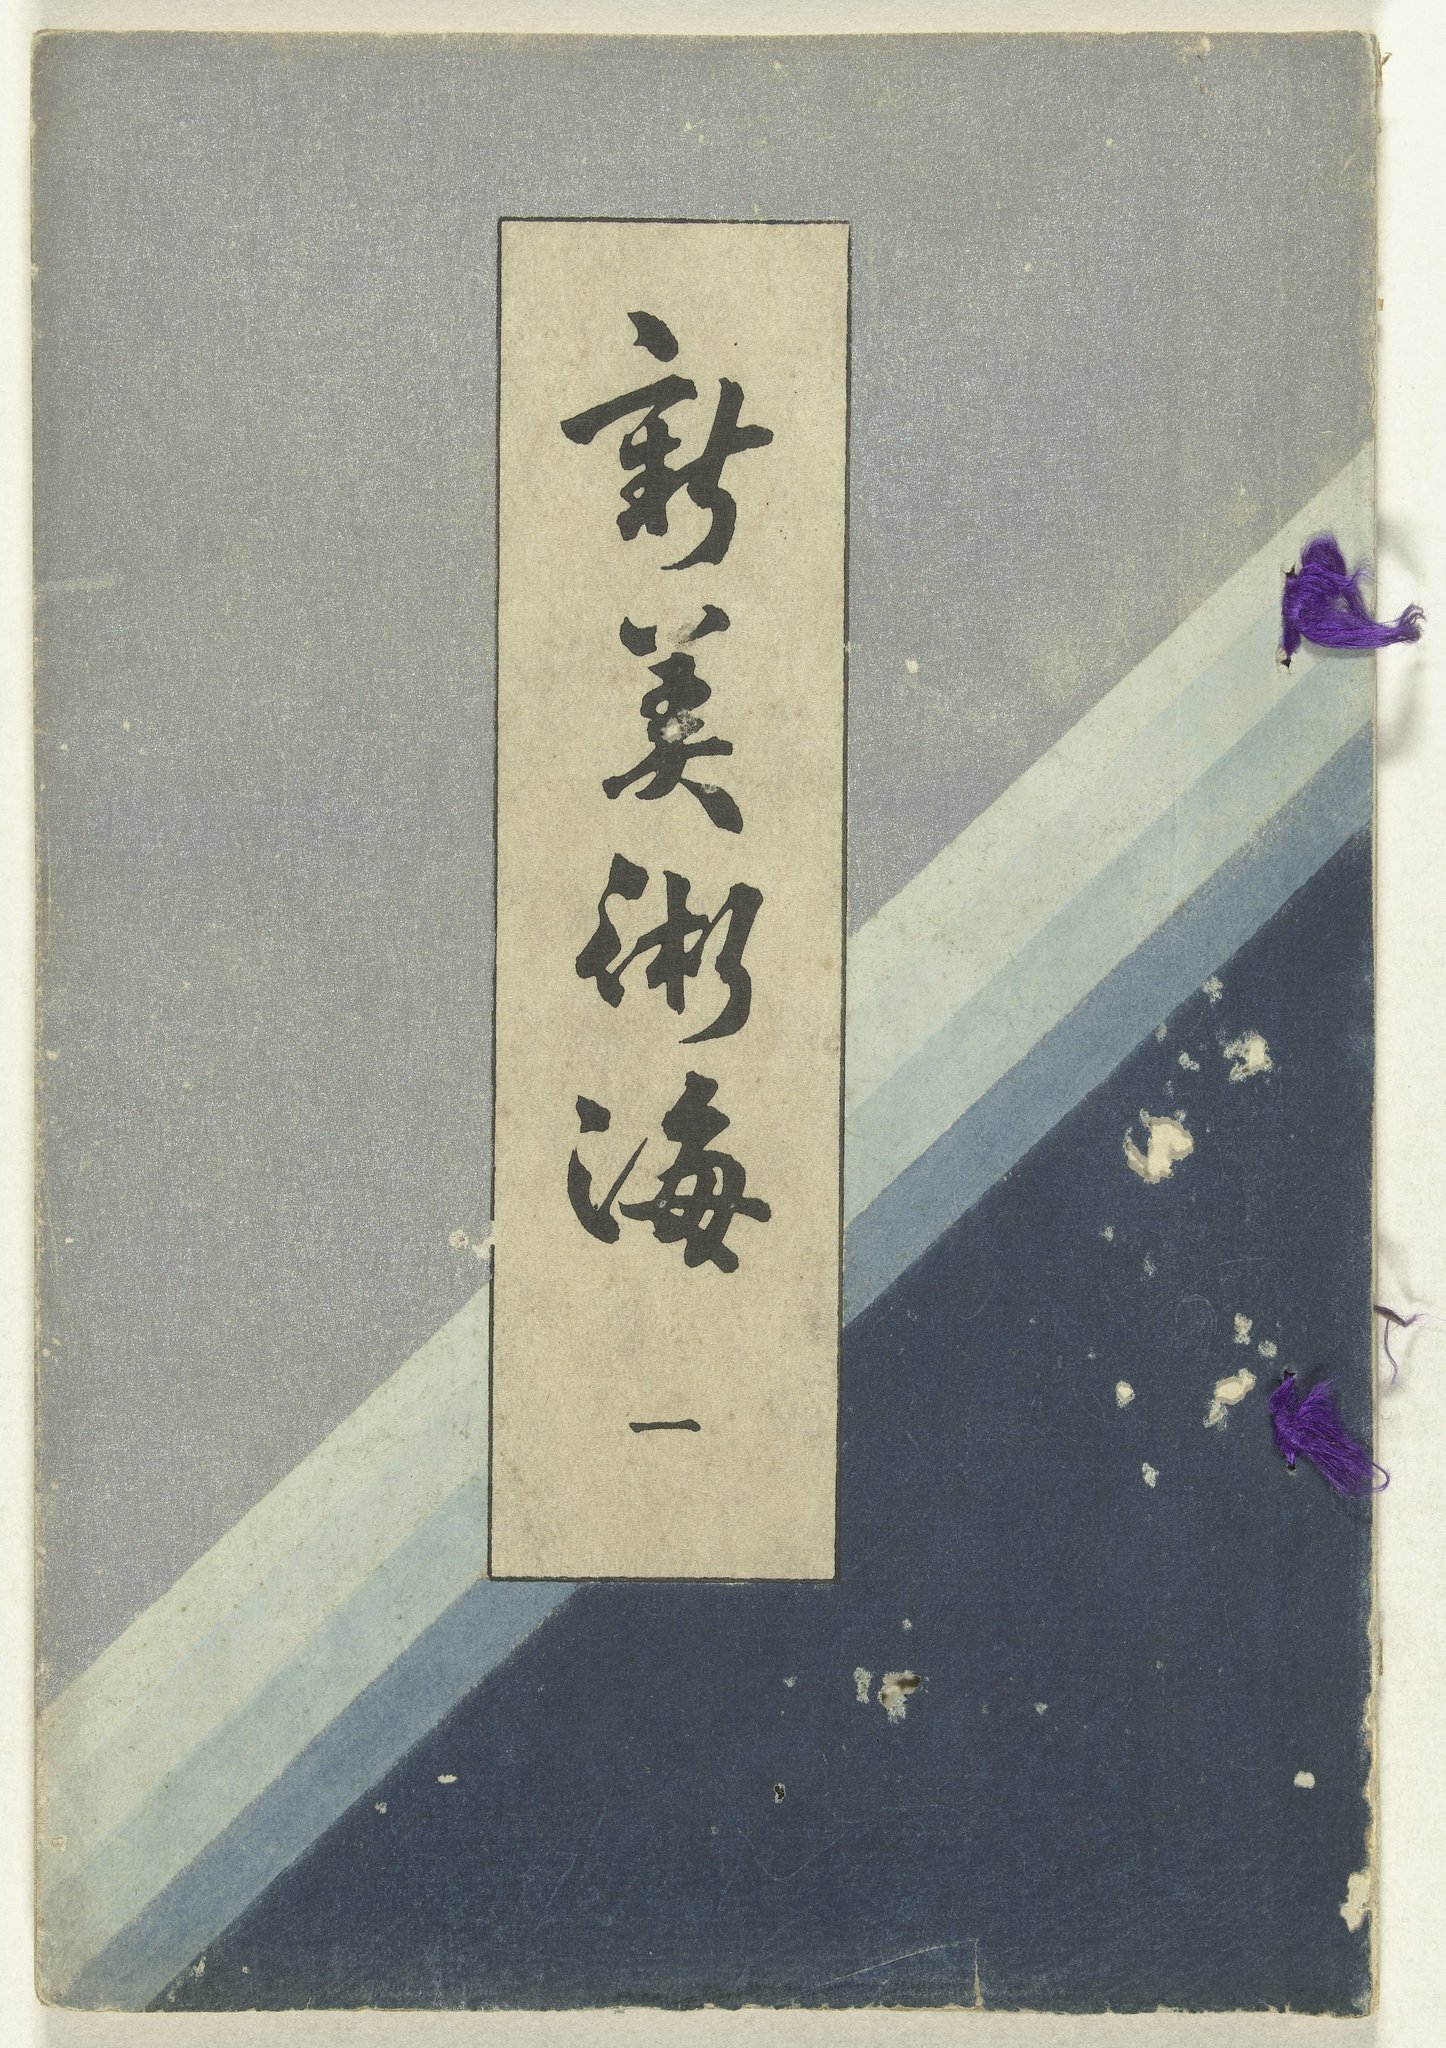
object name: book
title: Shin bijutsukai - ichi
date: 1902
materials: gold powder, paper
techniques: woodcut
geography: kyoto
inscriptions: date